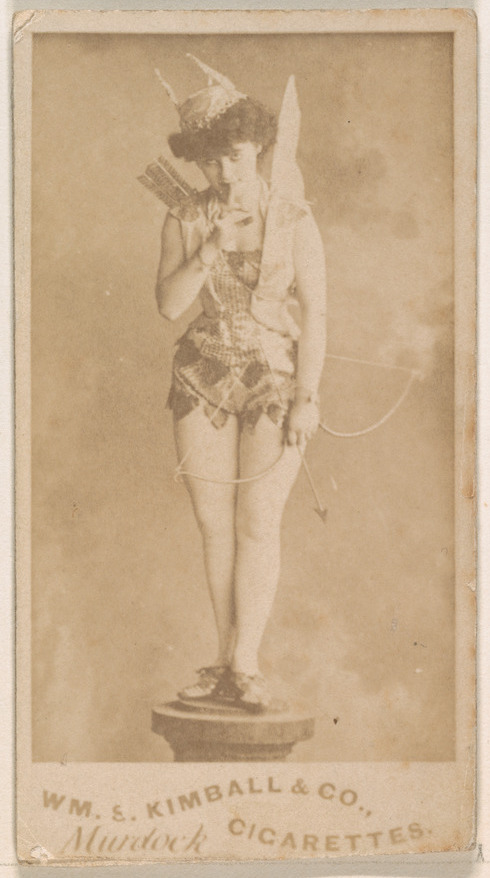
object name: photograph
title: Daisy Murdock, from the Actresses series (N203) issued by Wm. S. Kimball & Co.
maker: william s. kimball & company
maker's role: publisher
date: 1889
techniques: color lithograph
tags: portraits,women,actresses